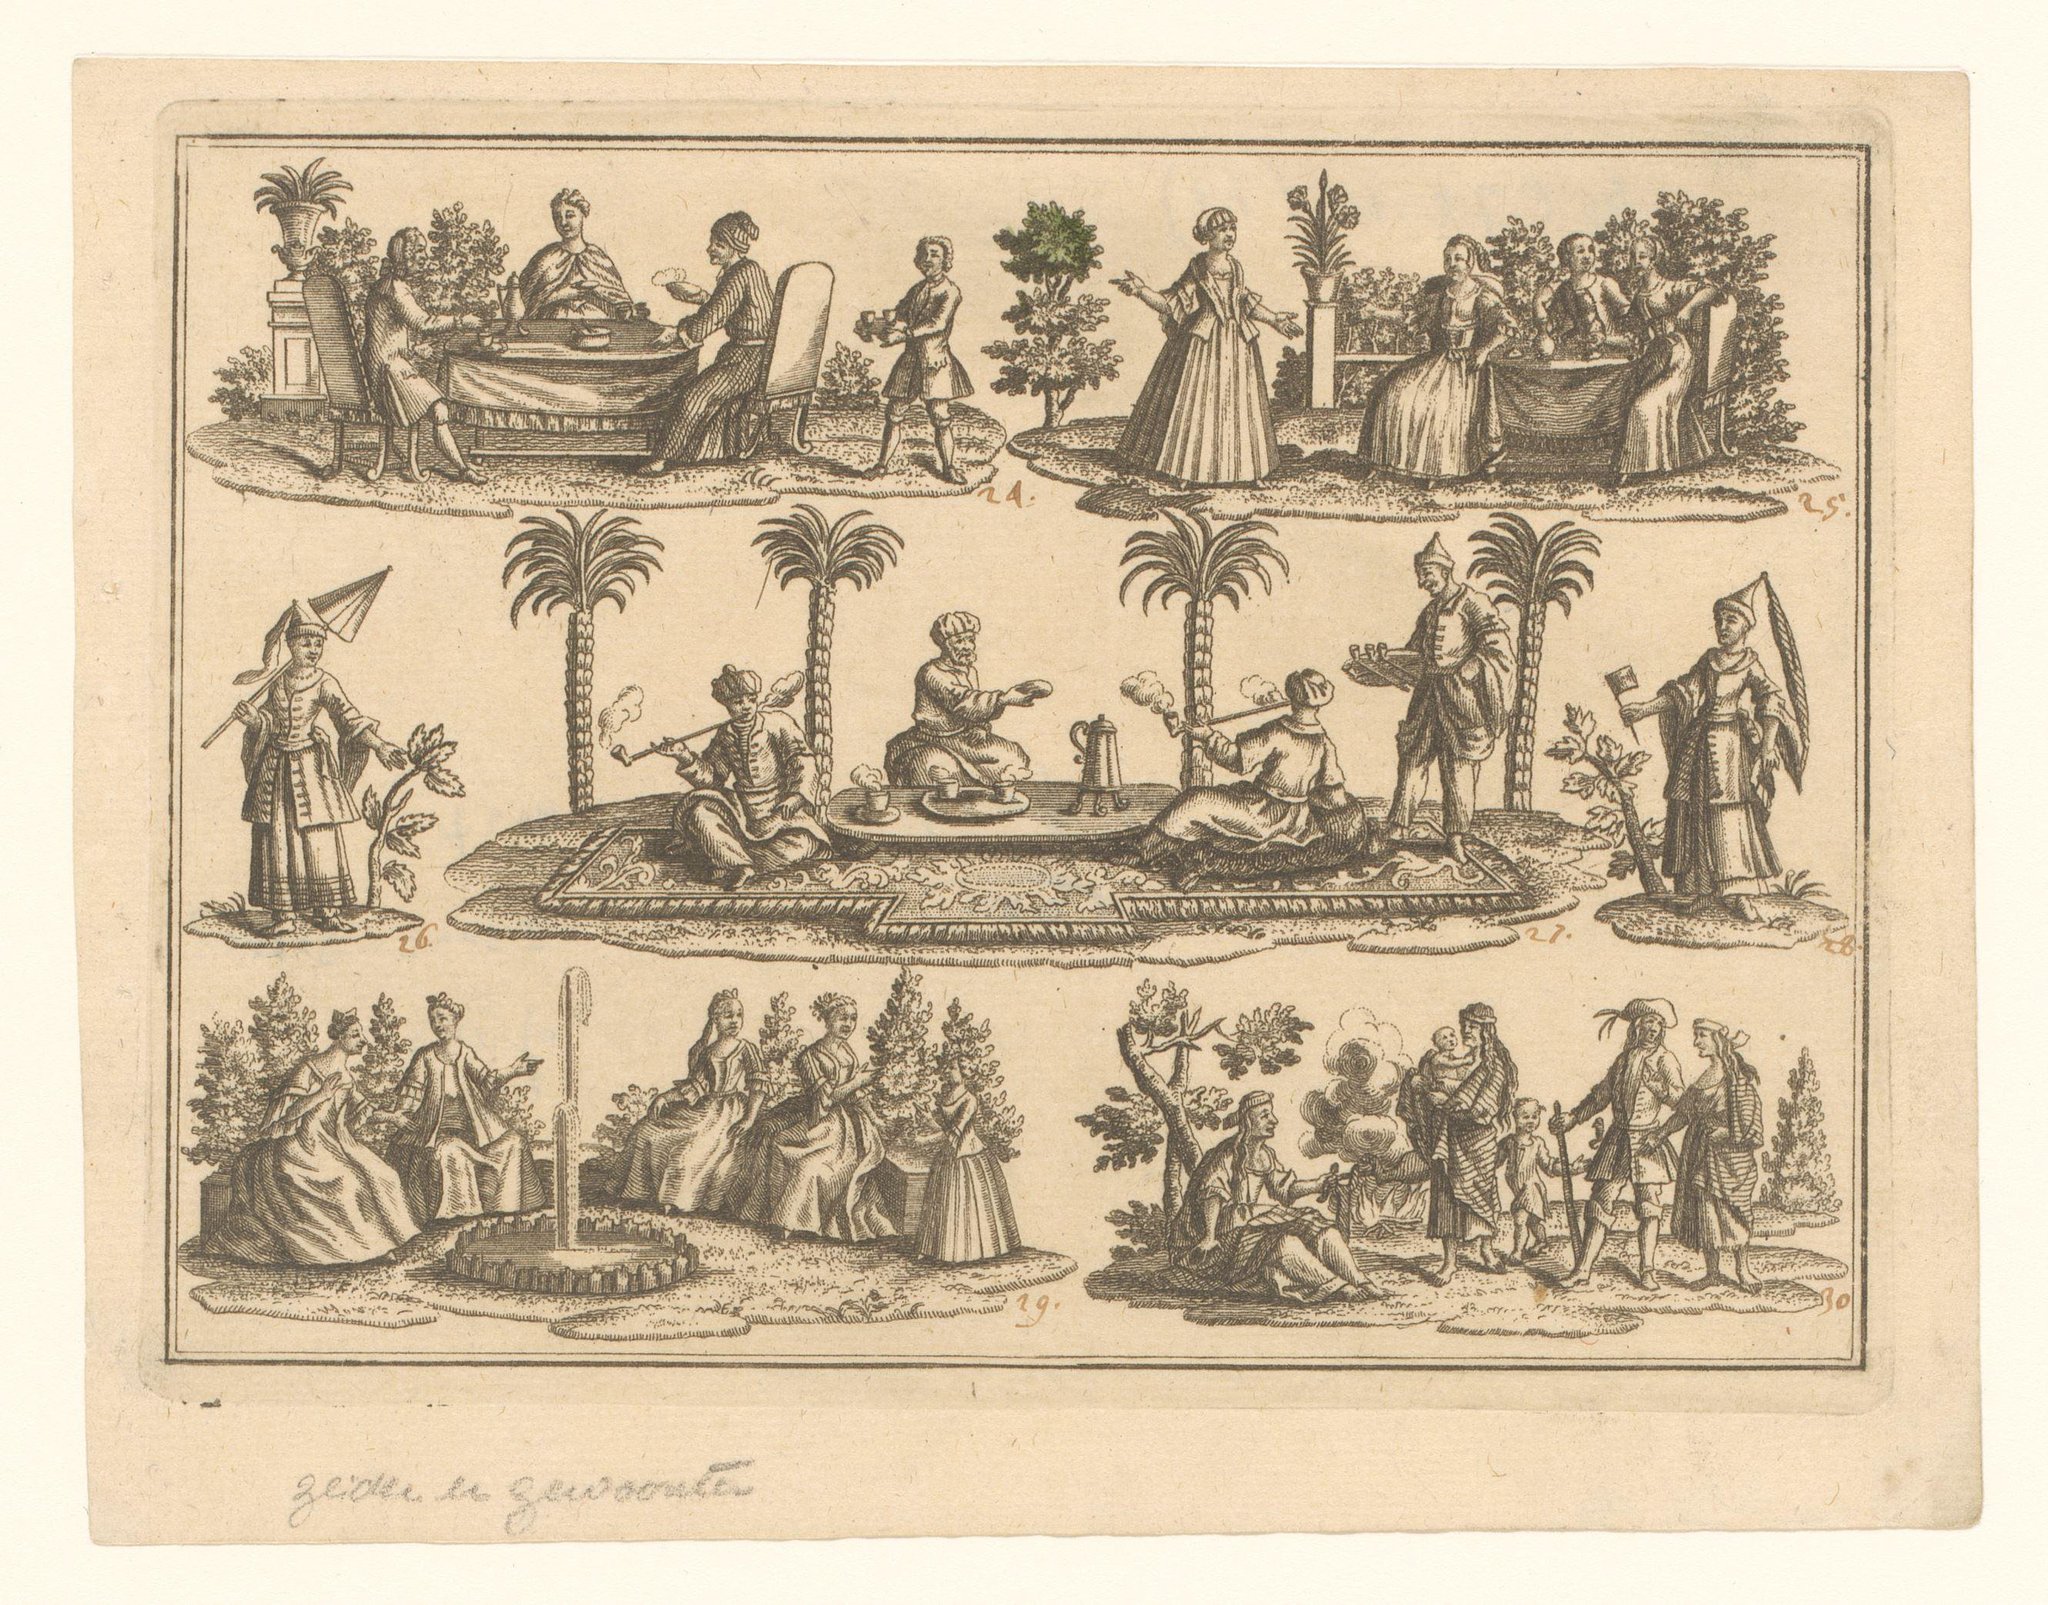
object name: print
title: Verschyde Playsante Geselschappen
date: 1718-1757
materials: paper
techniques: etching, hand coloring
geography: northern netherlands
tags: garden fountain, head-gear: turban, pipe ~ tobacco (+ taking (particular) foodstuffs: eating, drinking, smoking, chewing, etc.), cup of tea (+ taking (particular) foodstuffs: eating, drinking, smoking, chewing, etc.)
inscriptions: collector's mark: Lugt 2228, number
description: Zeven landschappen met gezelschappen. Centraal een gezelschap van drie mannen met tulbanden, die drinken en een pijp roken.